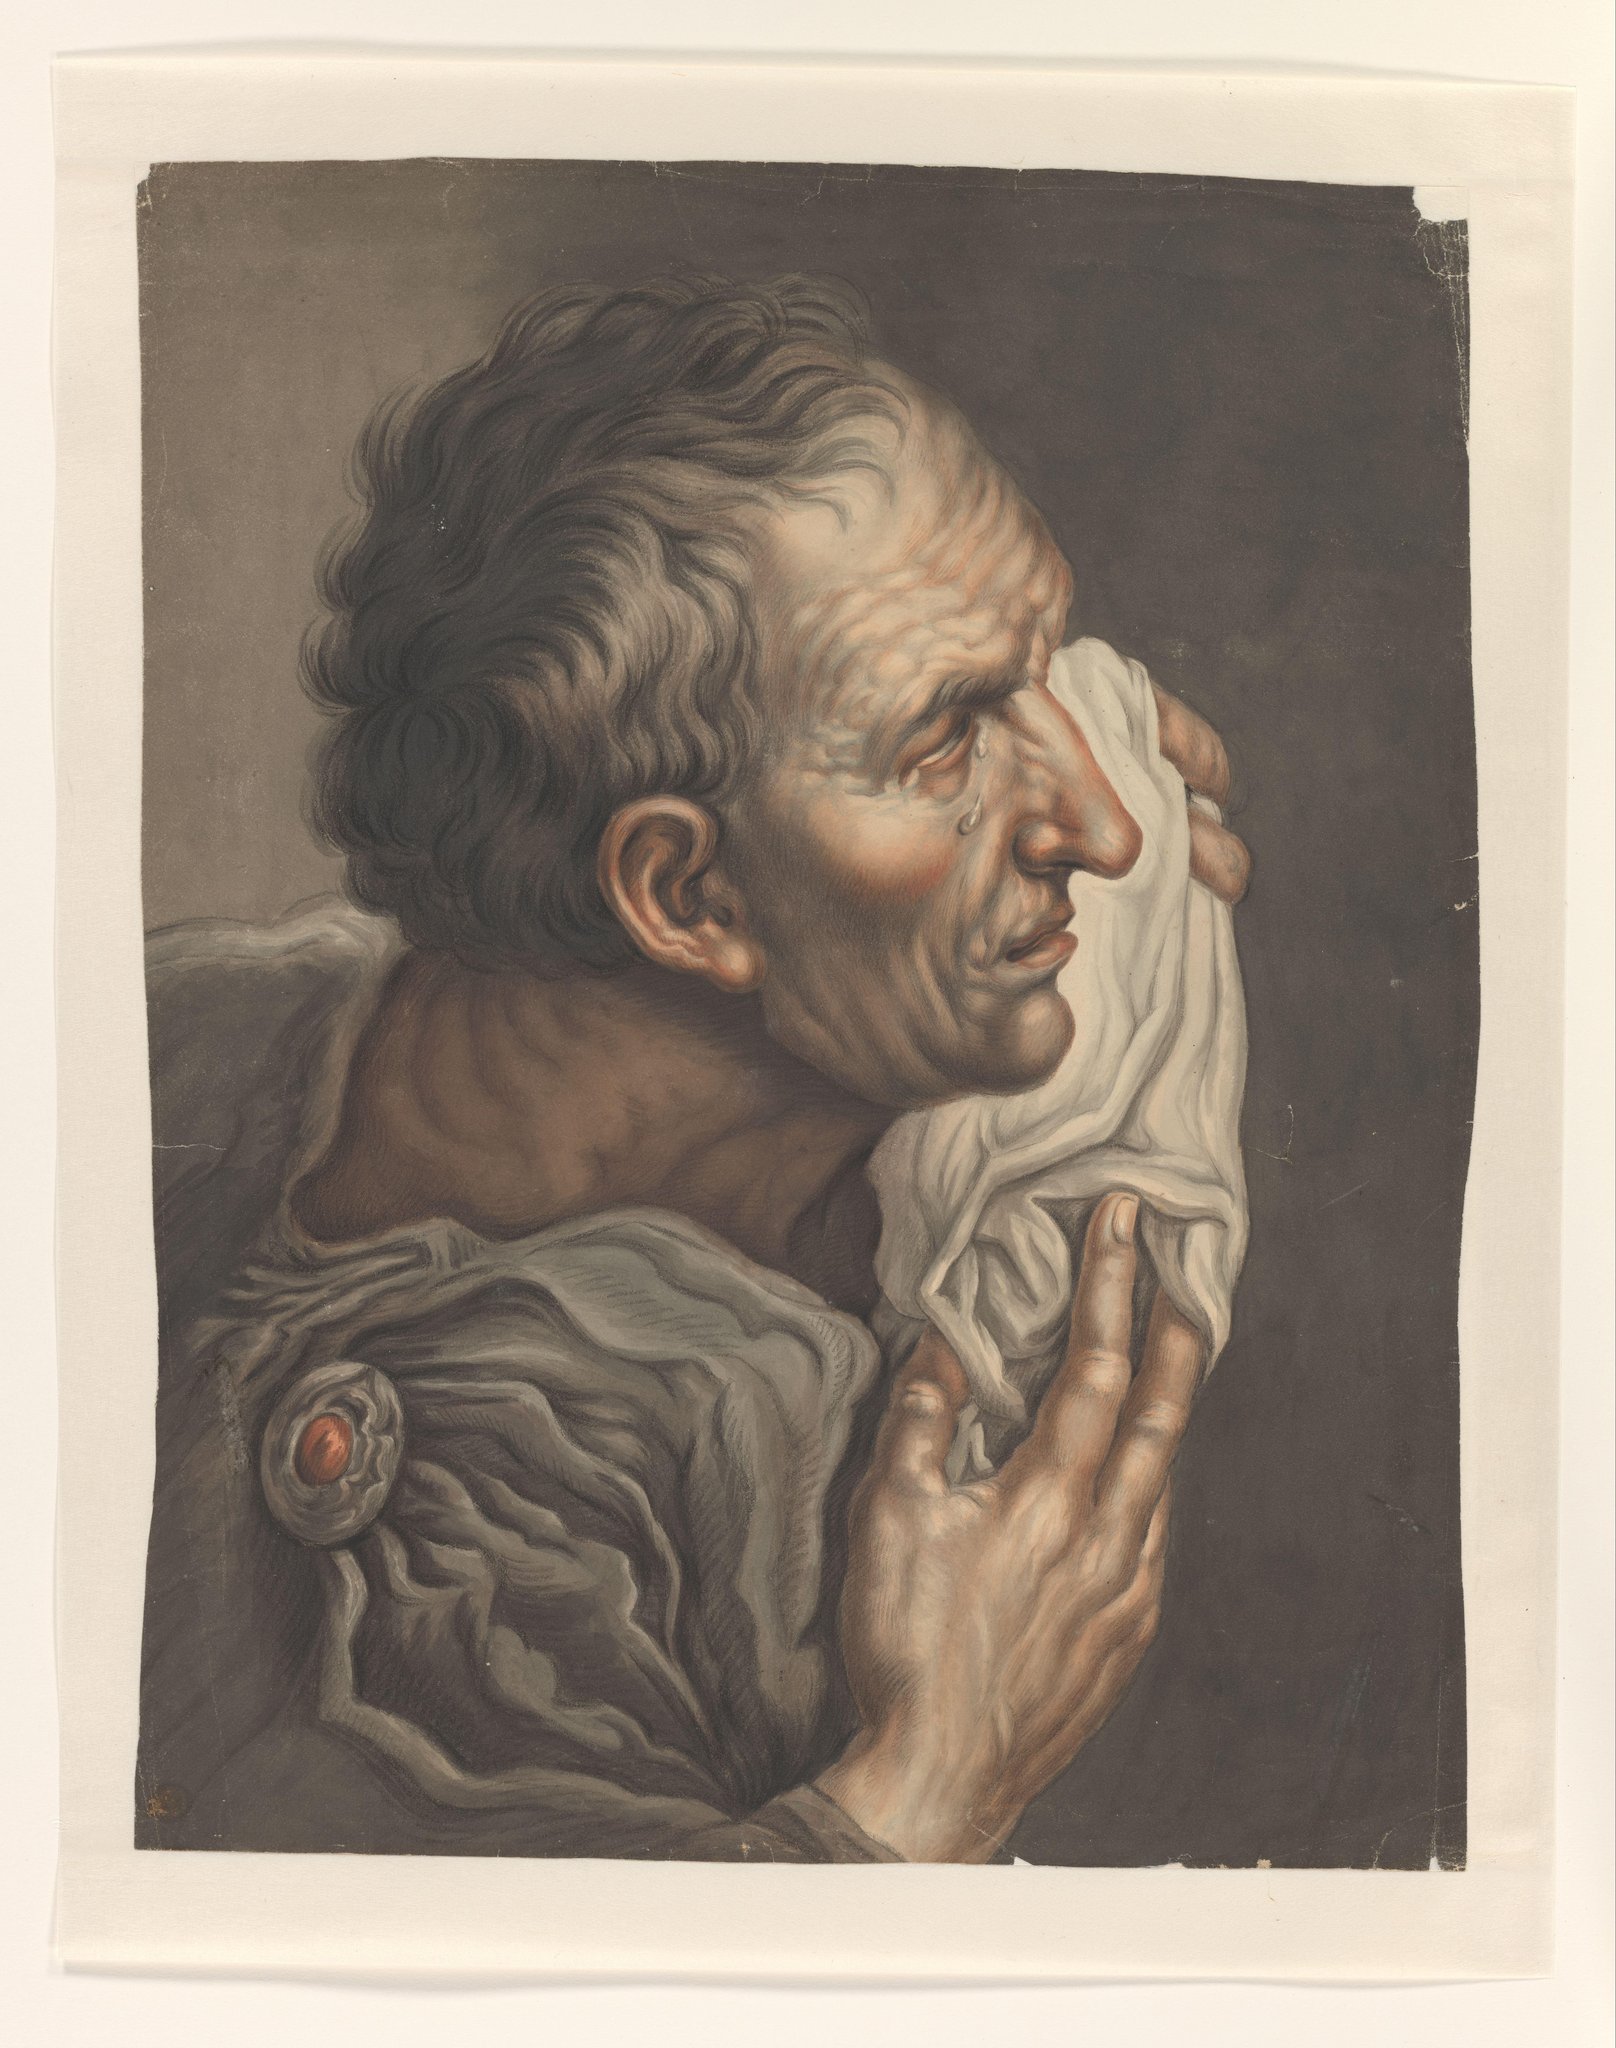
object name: drawing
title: Huilende man met doek, naar rechts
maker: s.a. van der heim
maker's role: draughtsman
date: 1825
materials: chalk, paper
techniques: brush